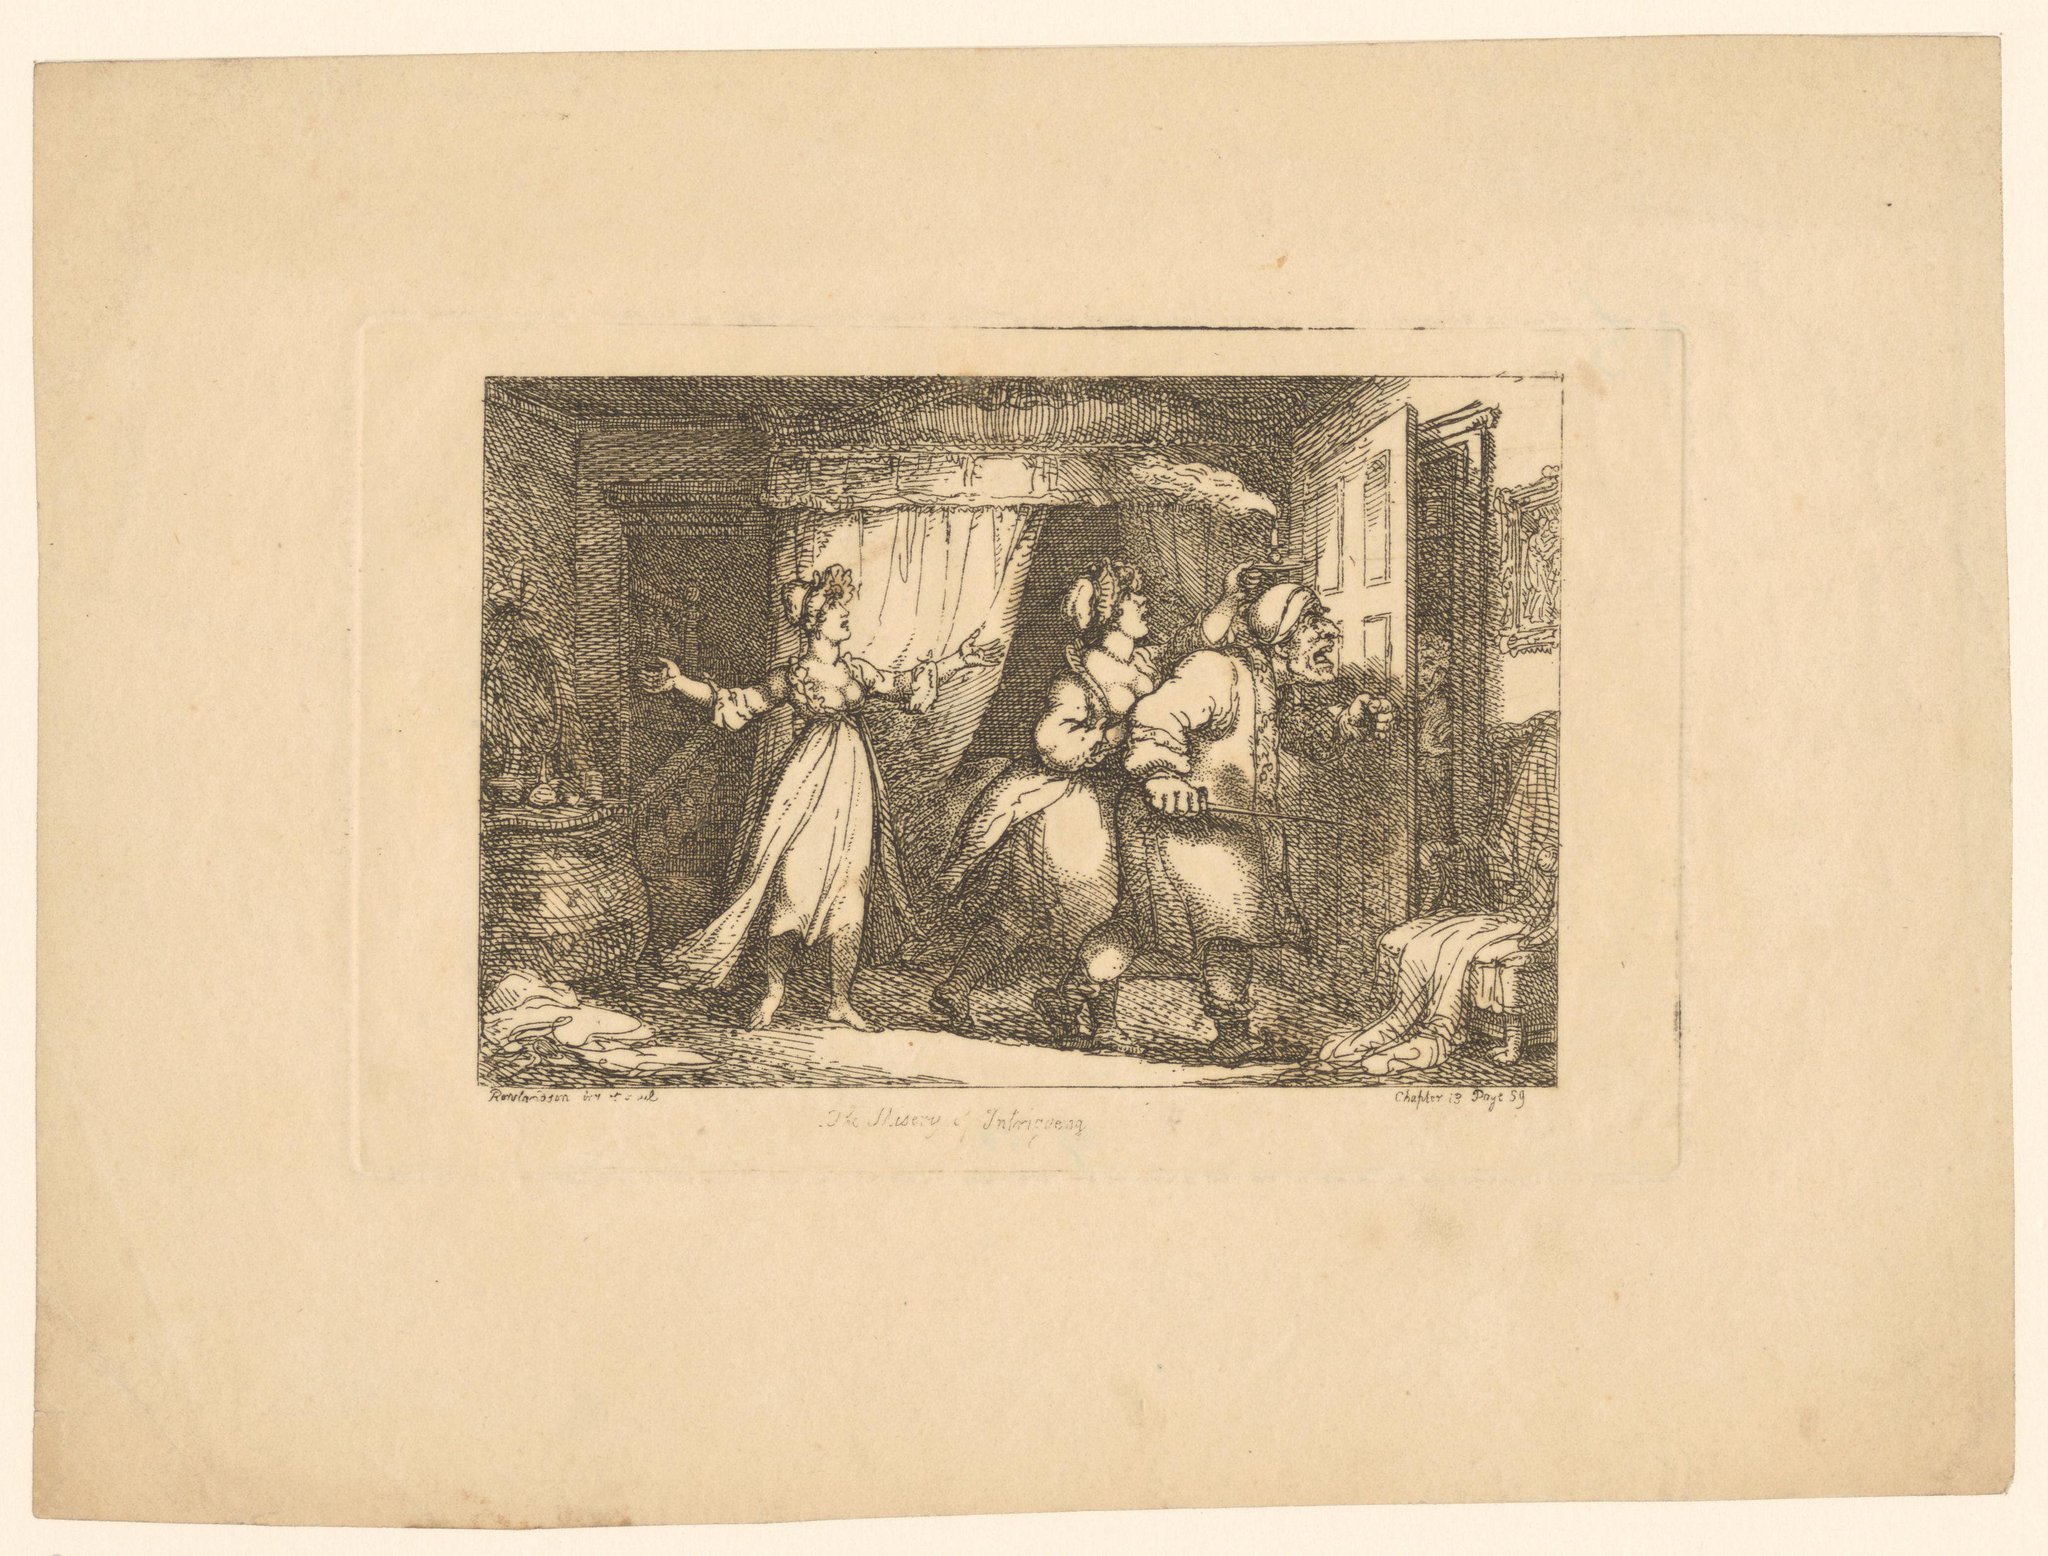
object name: cartoon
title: The Misery of Intrigueing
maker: thomas rowlandson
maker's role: draughtsman, print maker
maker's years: 1756-1827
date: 1766-1827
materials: paper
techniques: etching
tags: intrigue, bedroom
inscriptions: collector's mark: Lugt 2760, collector's mark: Lugt 2228